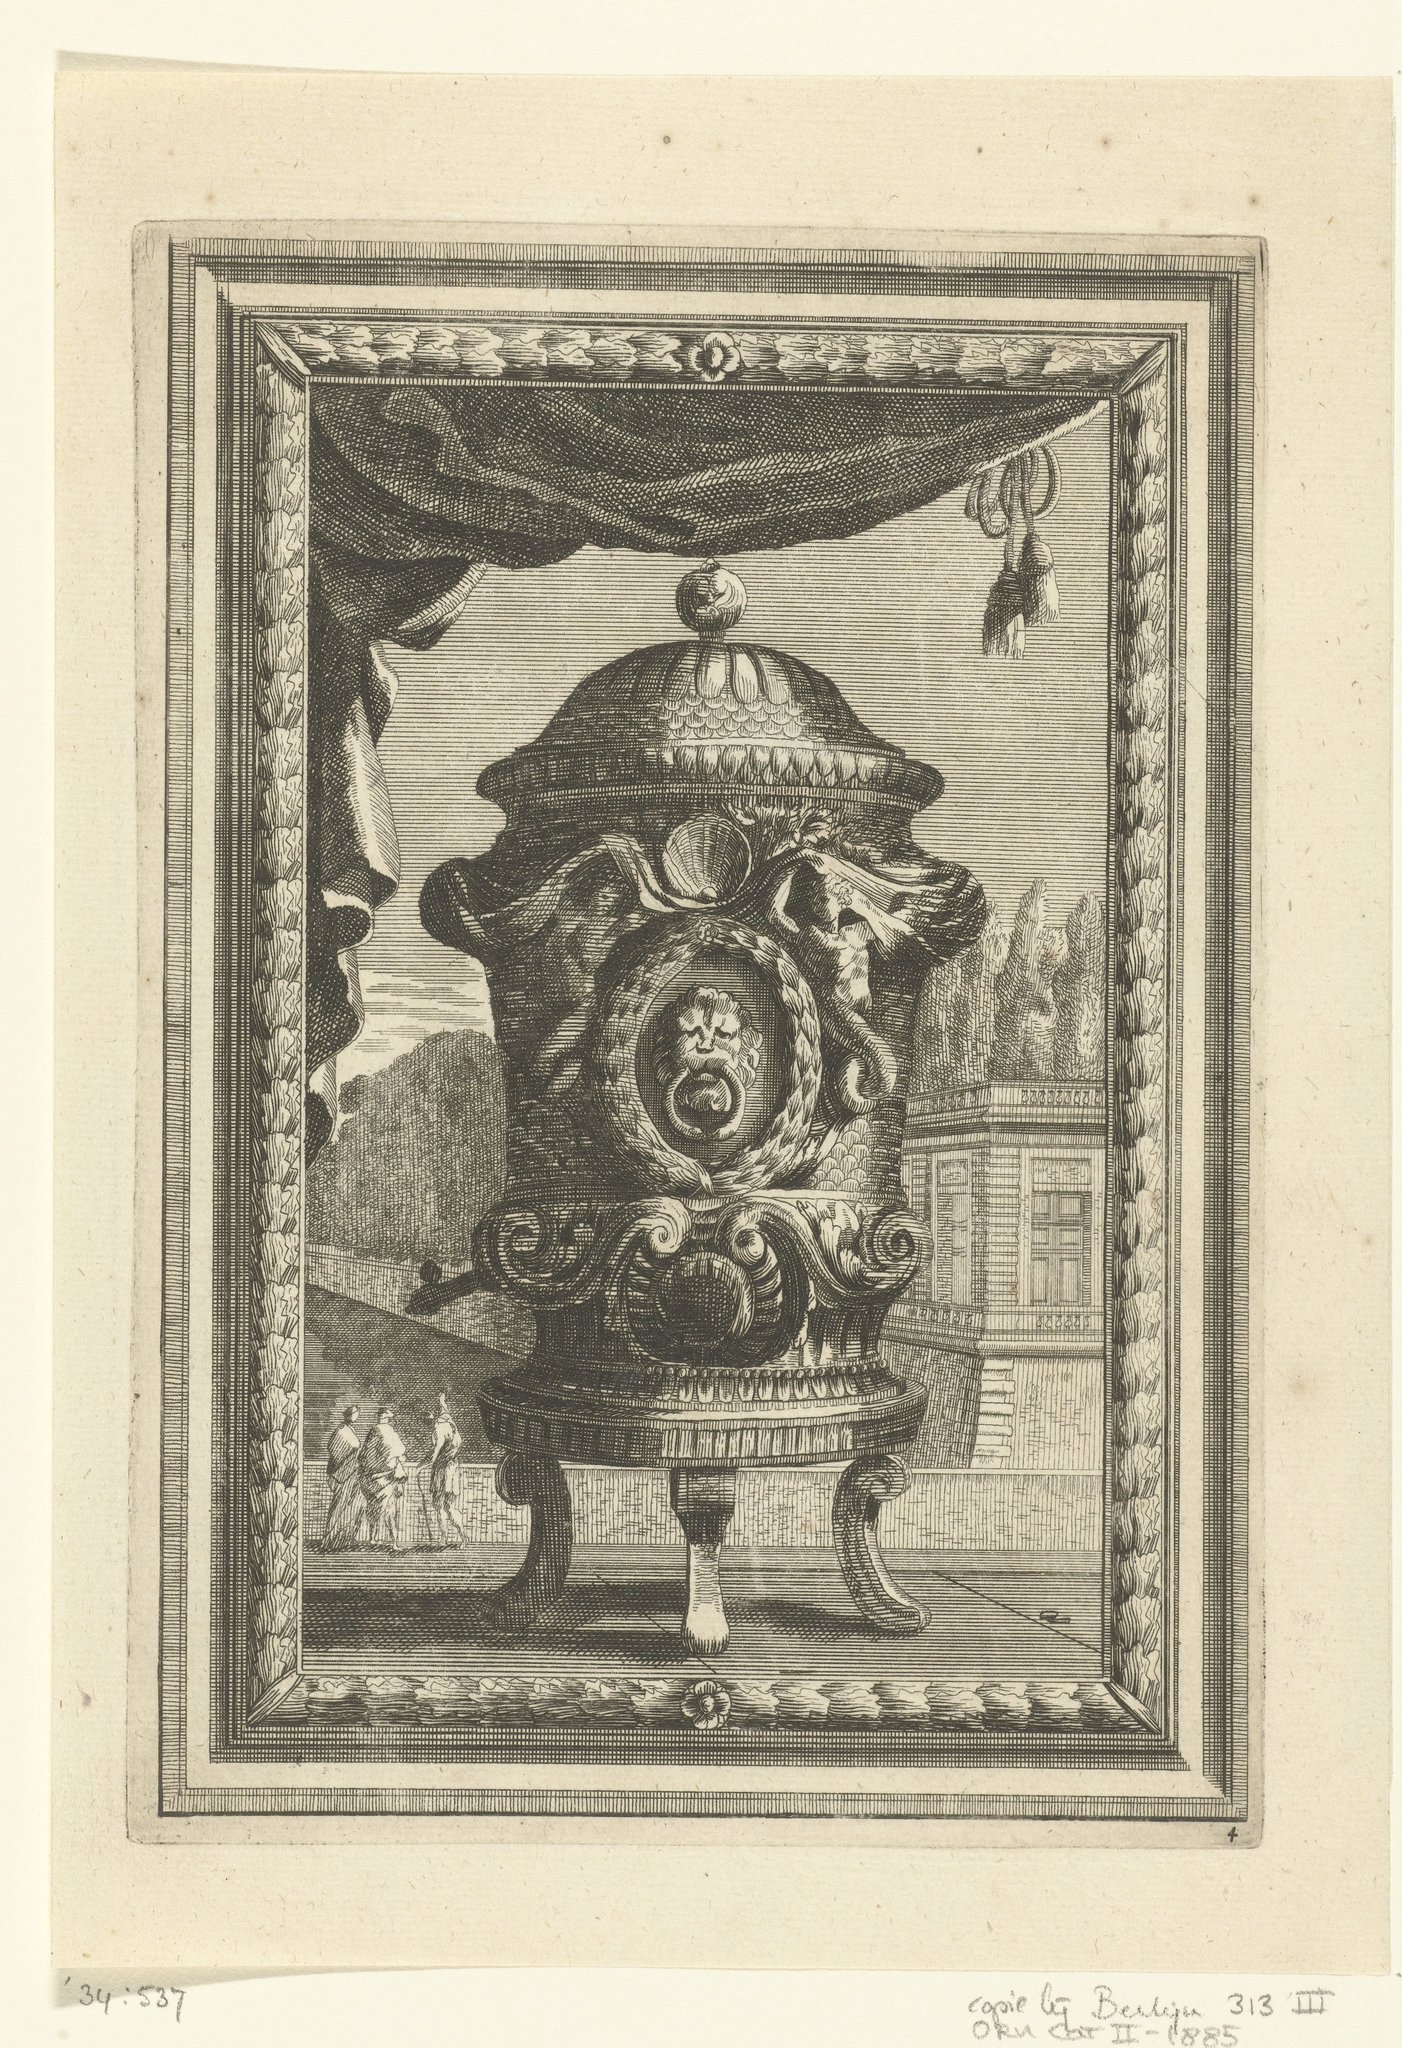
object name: ornament print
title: Waterbassin op driepoot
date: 1655-1678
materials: paper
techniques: etching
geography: france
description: Bassin gedecoreerd met ovaal medaillon te midden van twee tritons.